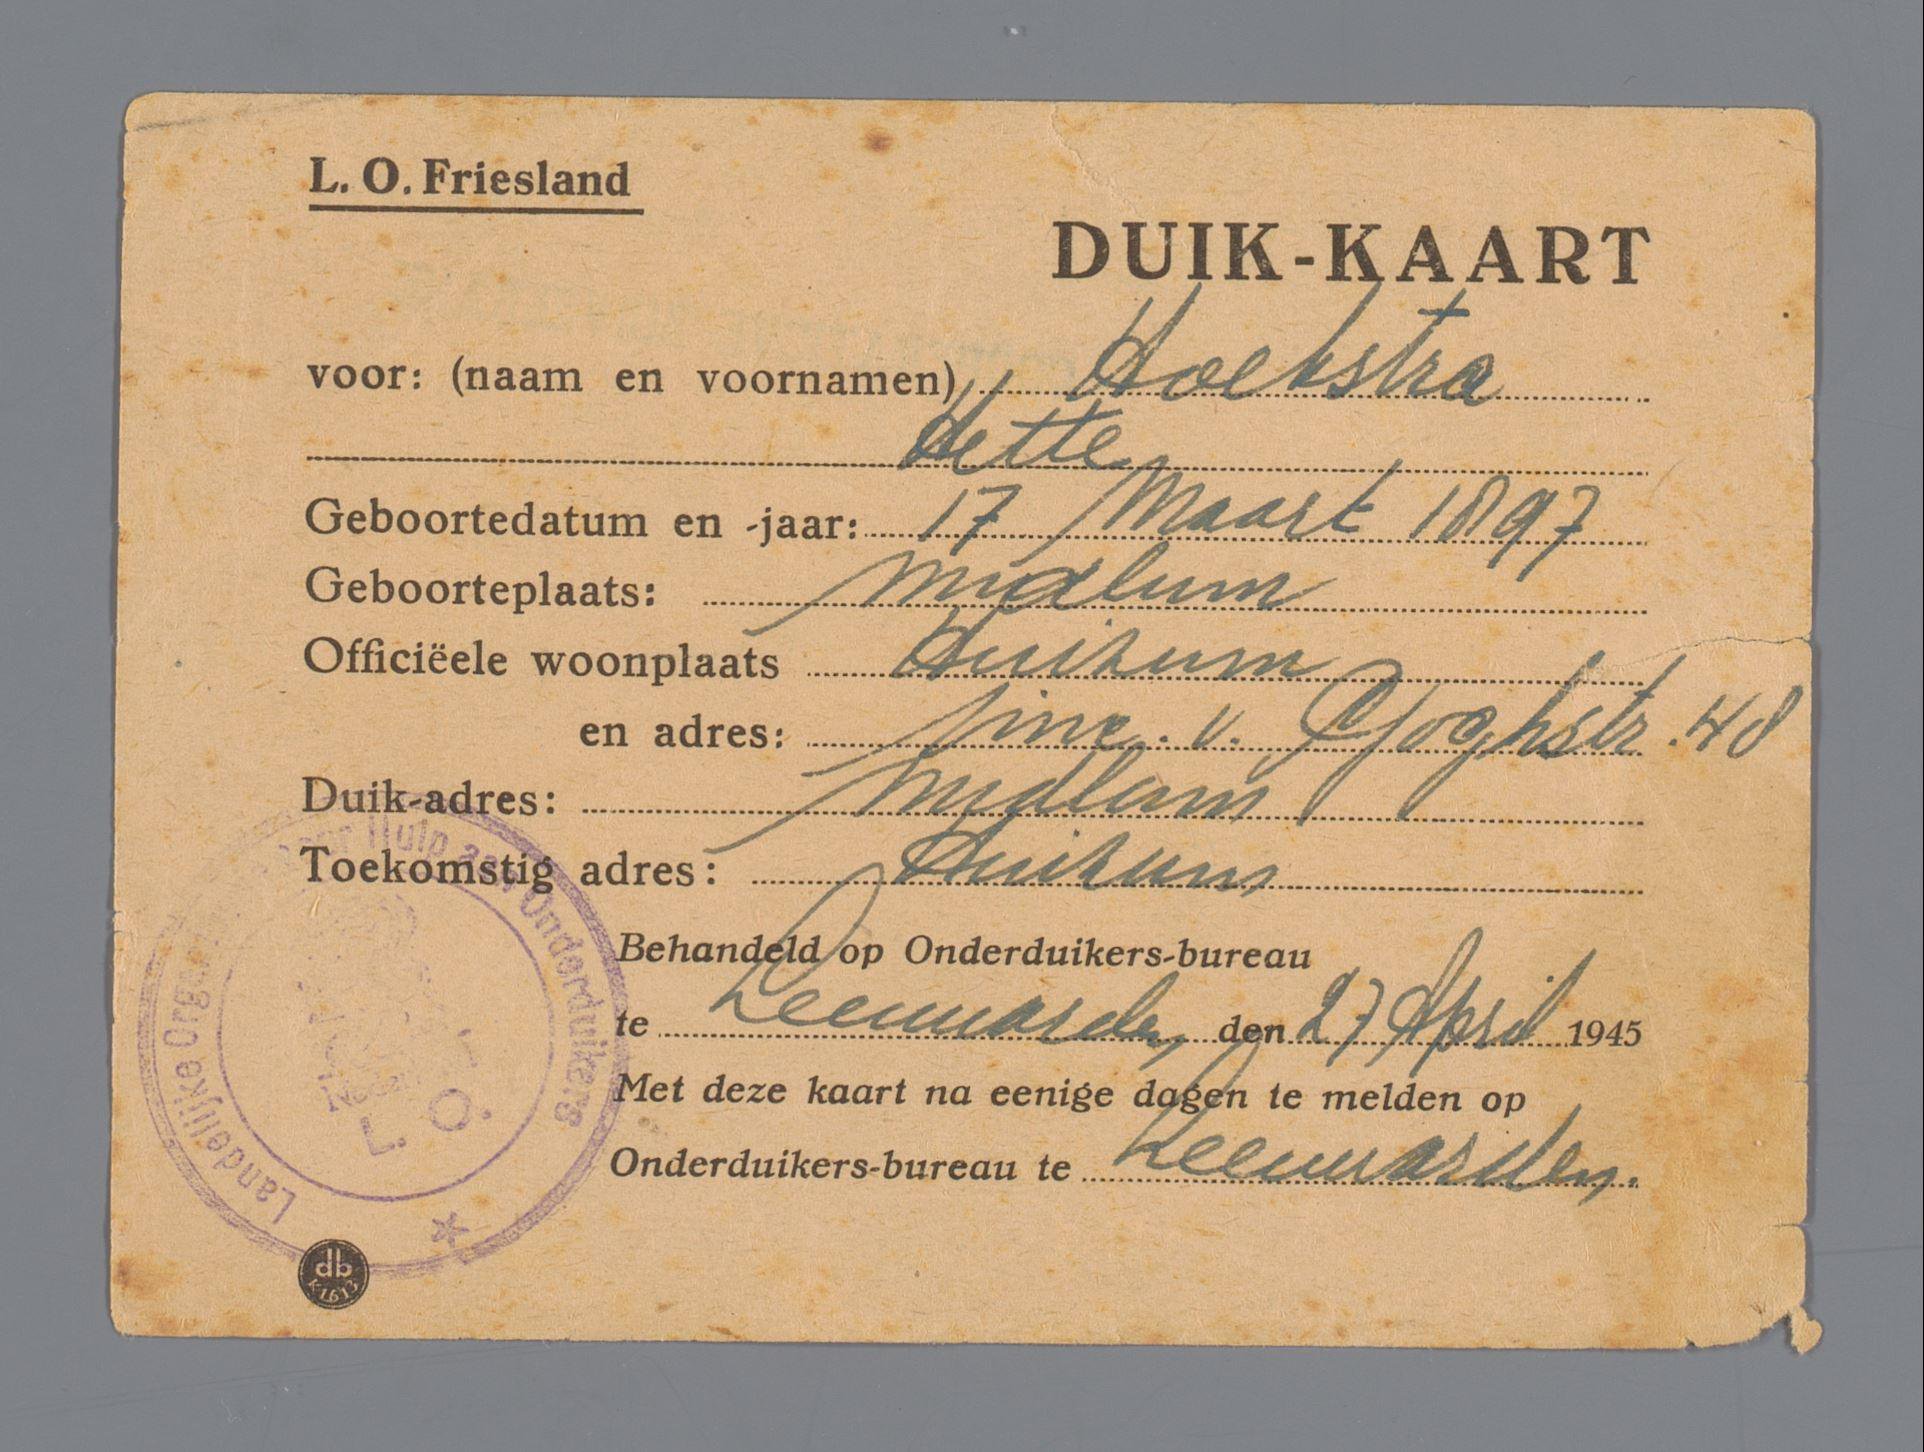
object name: document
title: Duikkaart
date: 1945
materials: ink, paper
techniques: printing, writing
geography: friesland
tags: netherlands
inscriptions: date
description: Document (duikkaart), gedrukt en met pen ingevuld, waarmee H. Hoekstra als onderduiker wordt geregistreerd. Gemerkt: stempel: 'Nederland L.O. (...)'.